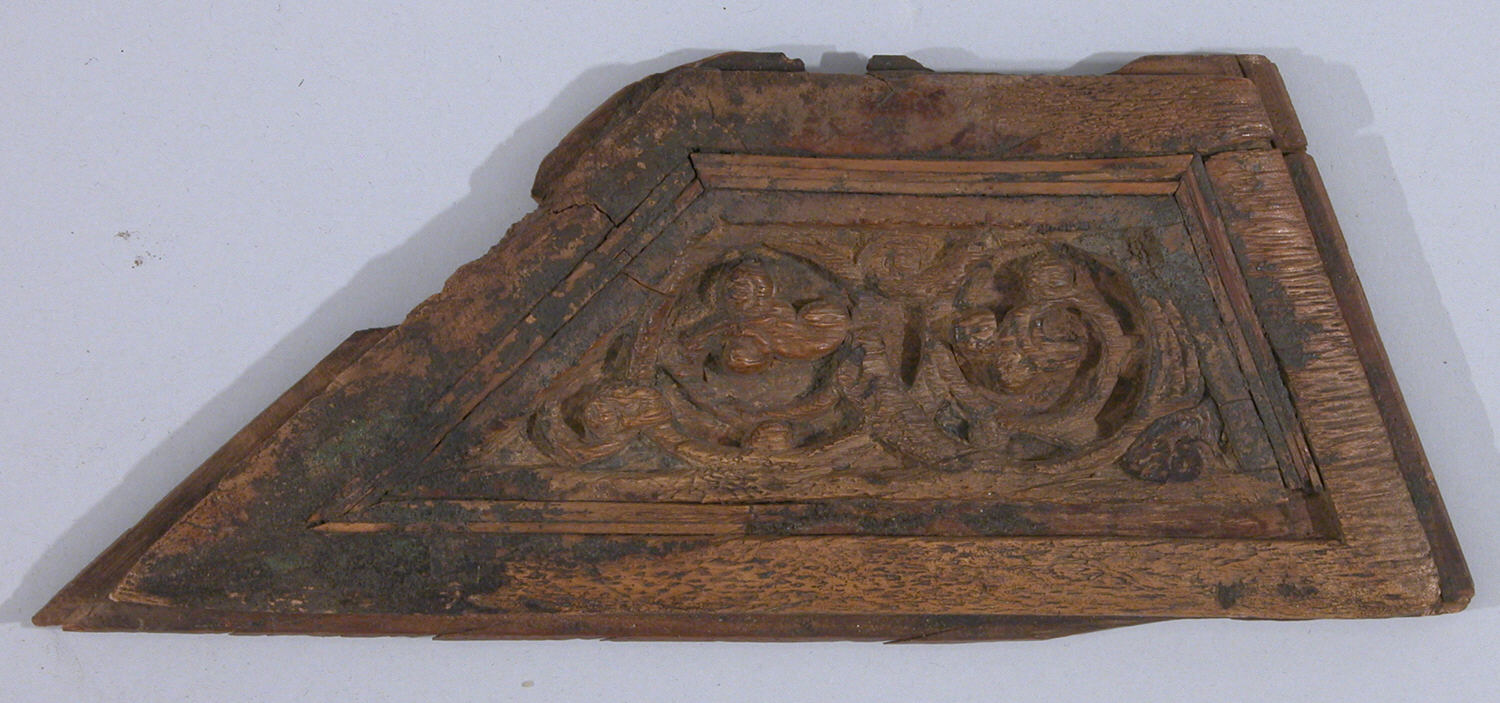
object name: panel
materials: wood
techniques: carving, inlay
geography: egypt